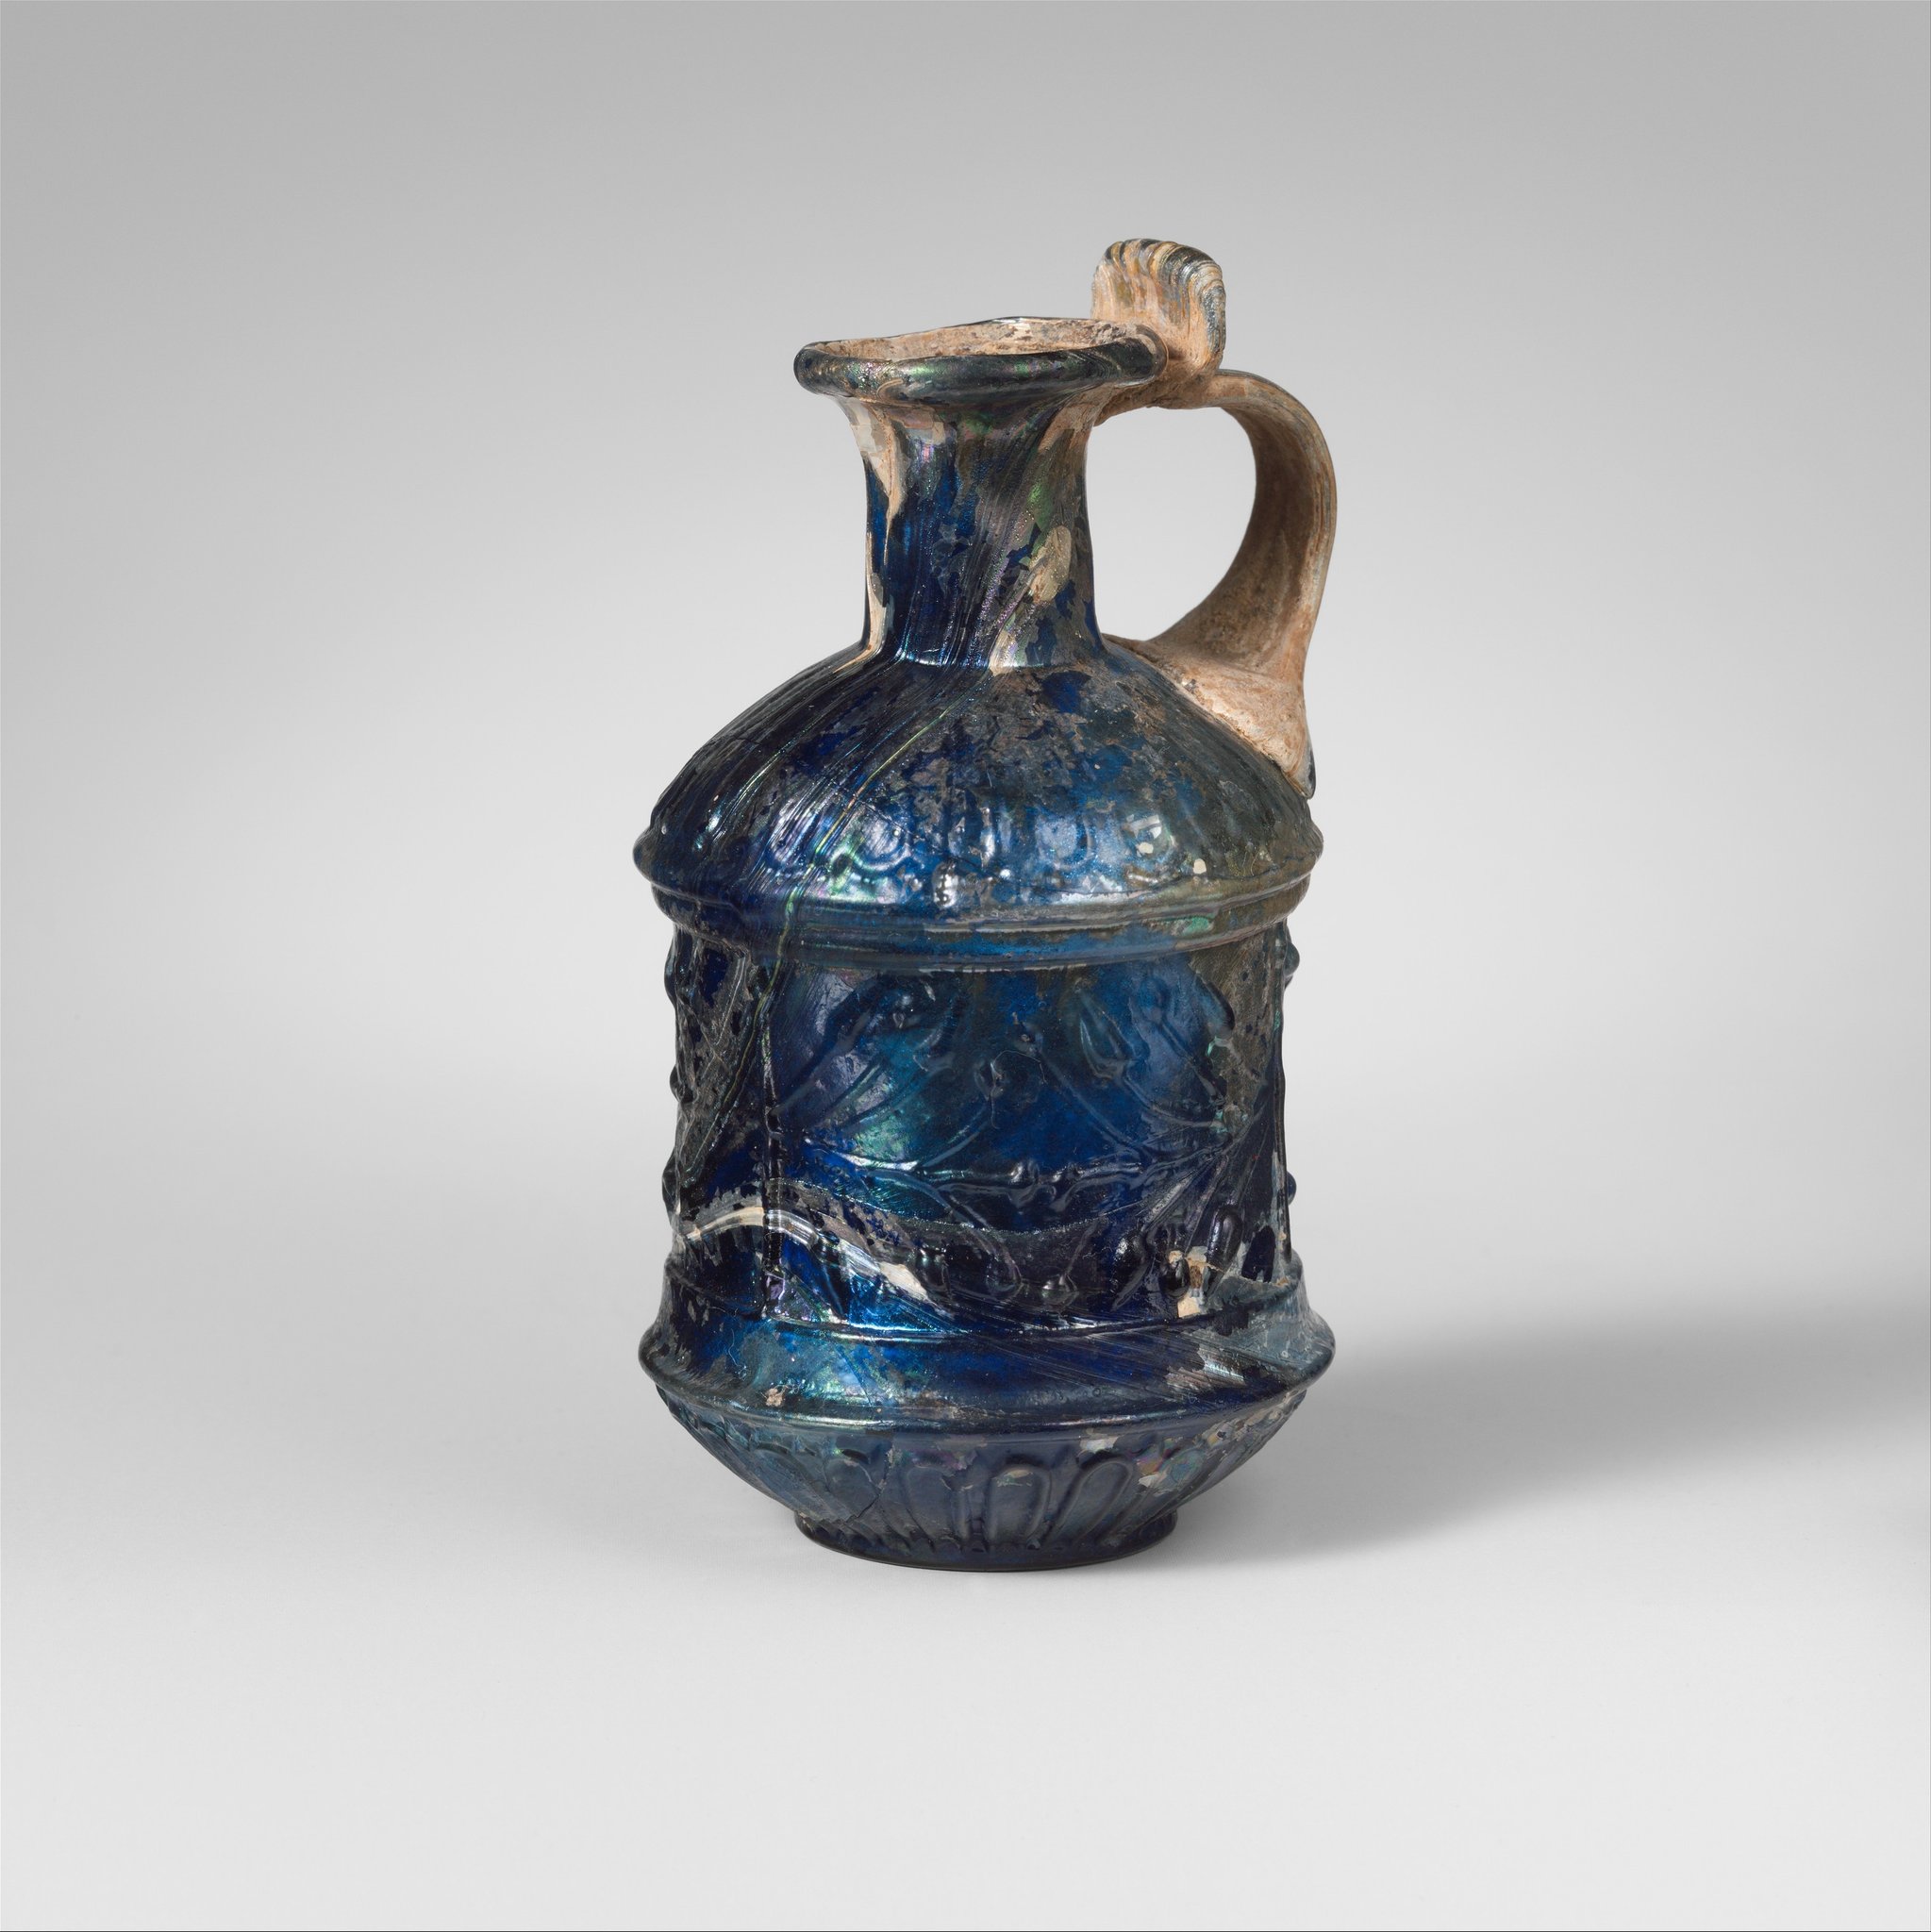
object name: jug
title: Glass jug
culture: roman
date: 1-50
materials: glass